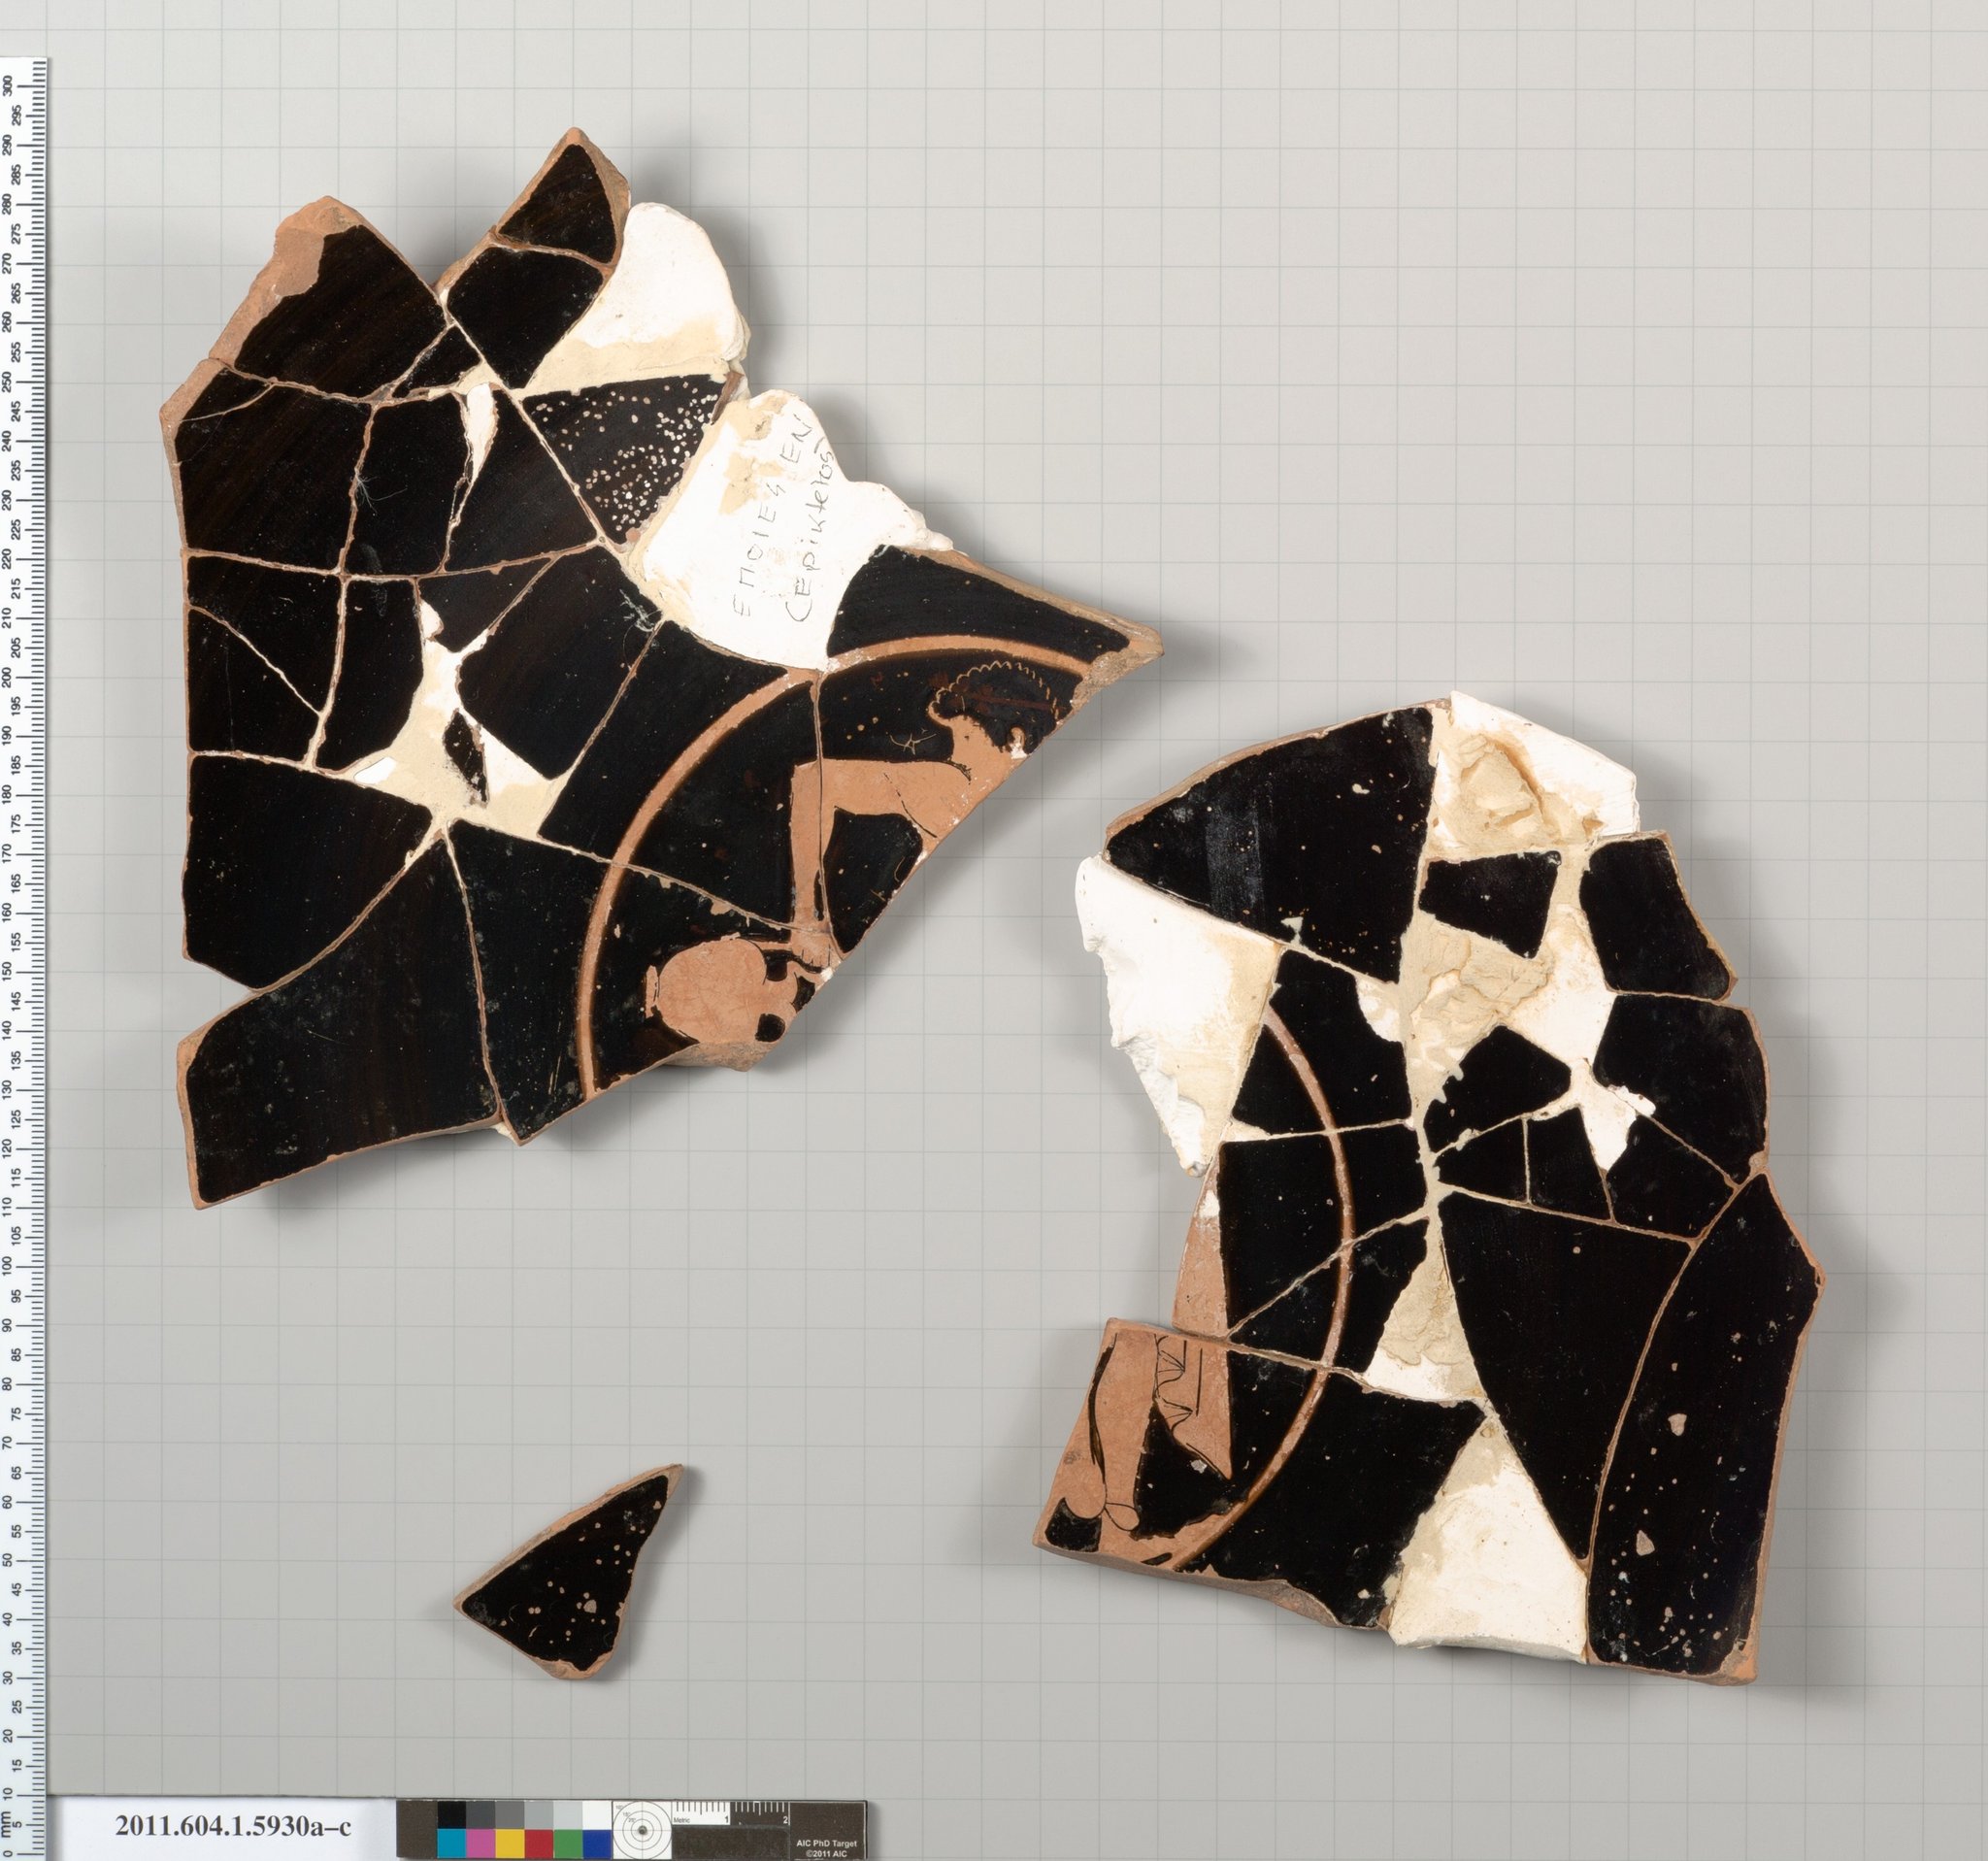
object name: kylix fragment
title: Terracotta fragments of a kylix (drinking cup)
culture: greek, attic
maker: epiktetos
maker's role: artist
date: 520-510 BCE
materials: terracotta